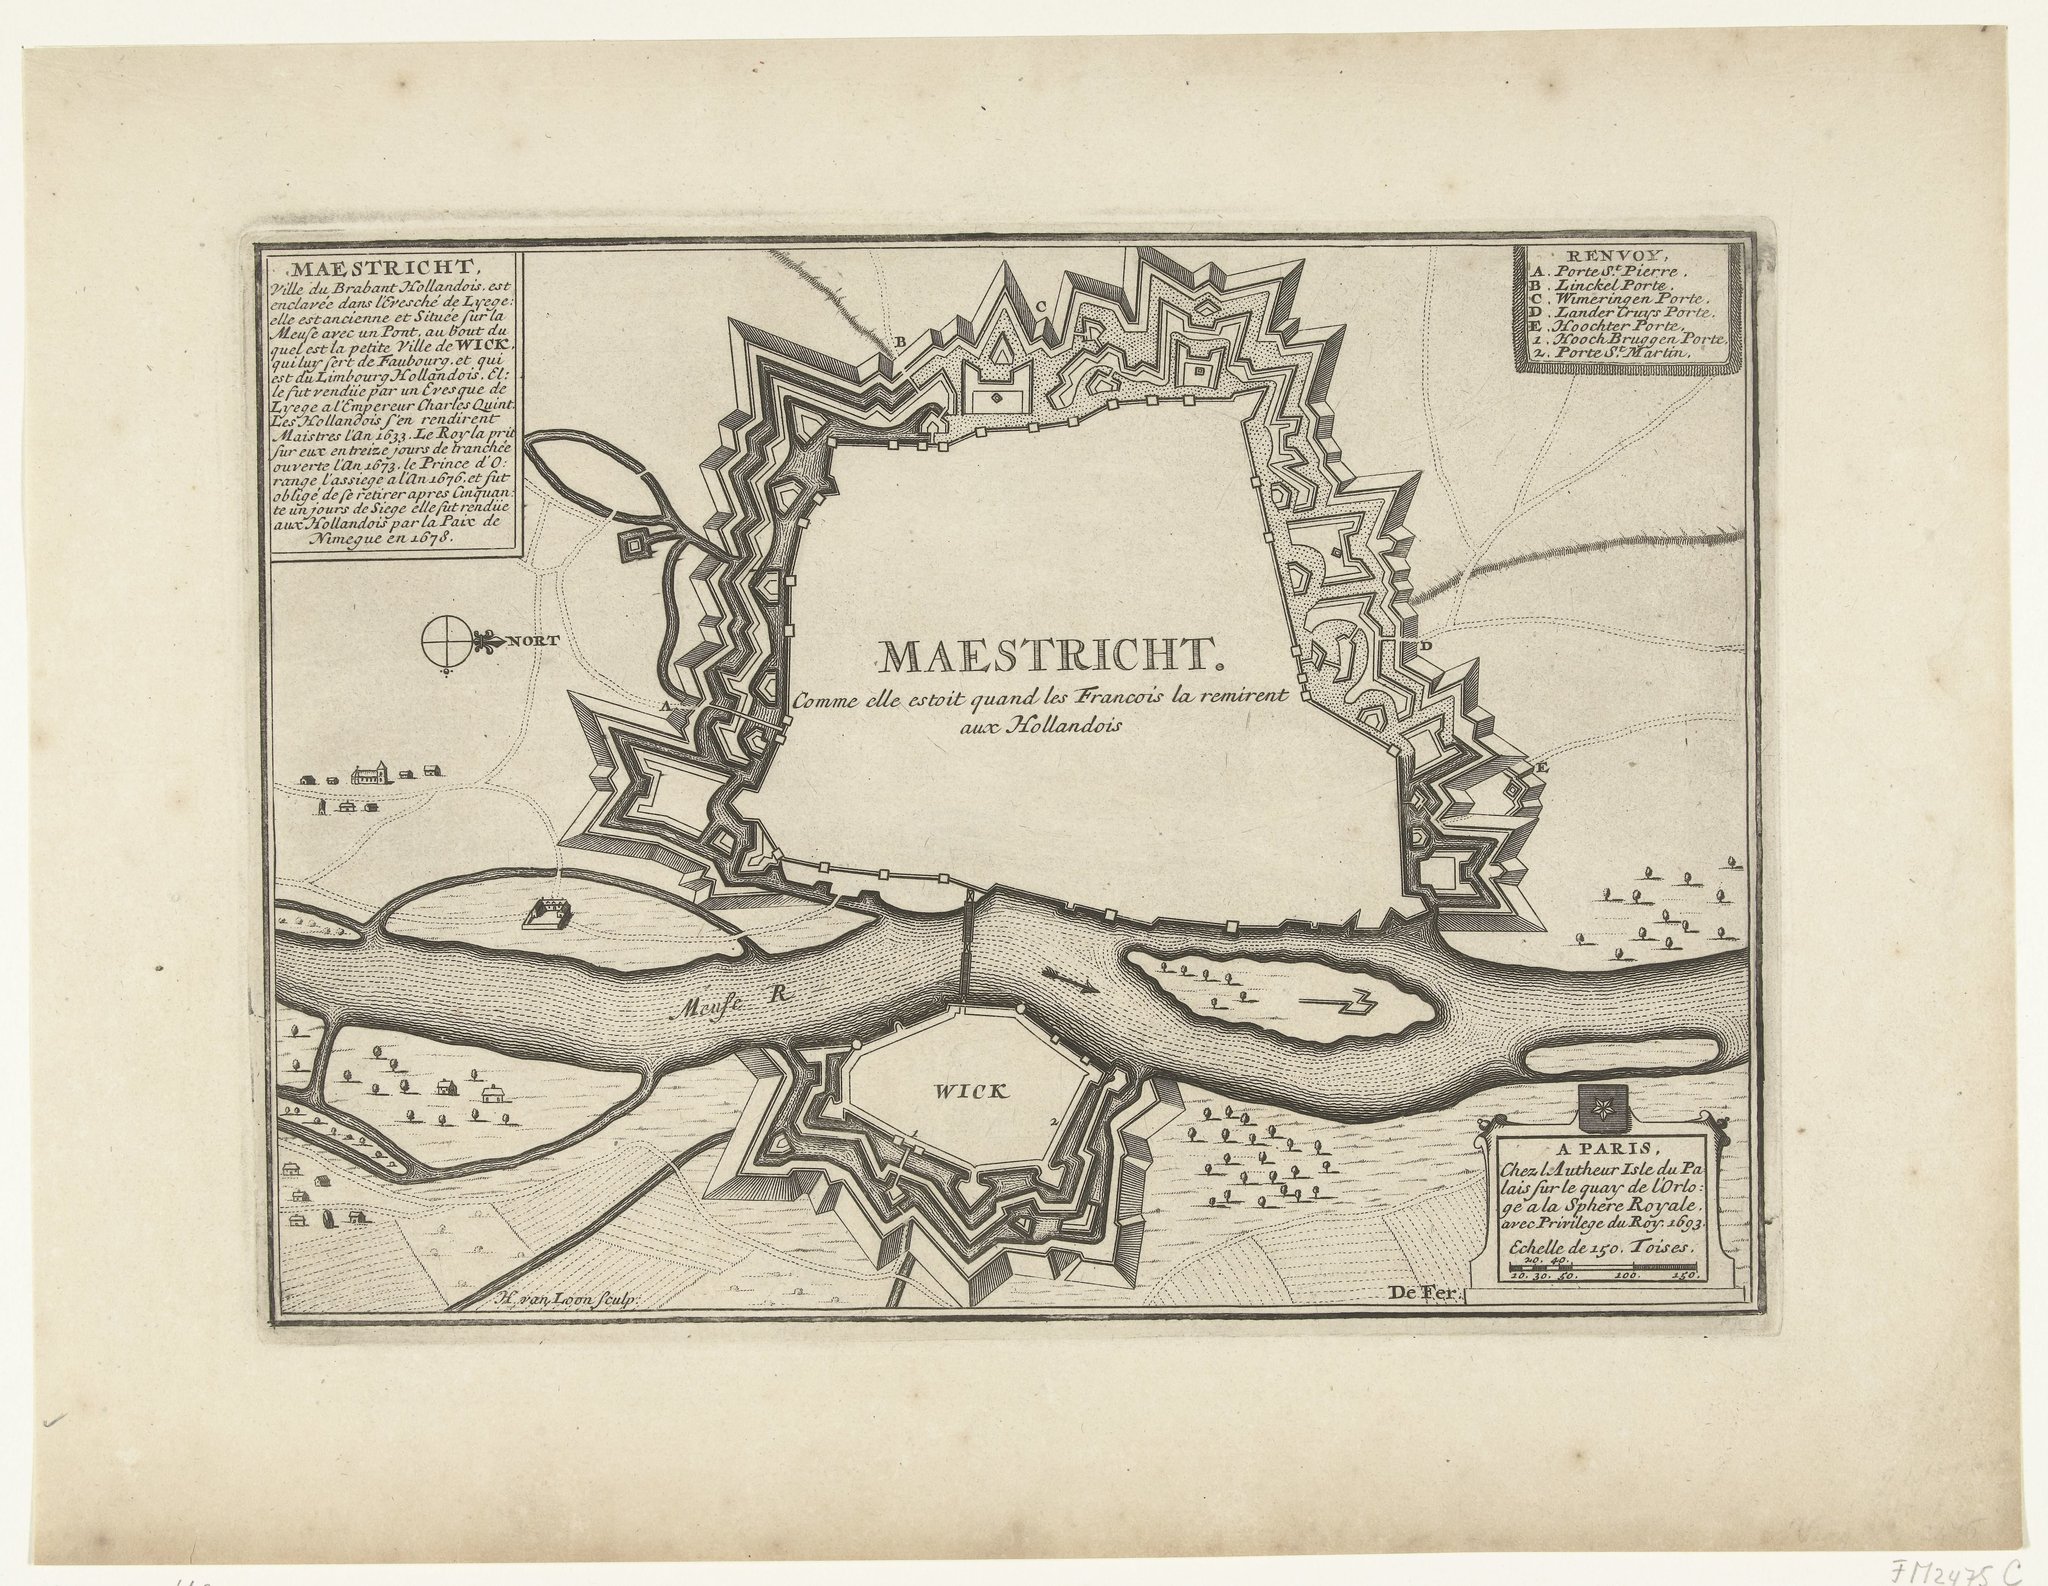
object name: print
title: Maestricht. Comme elle estoit quand les Francois la remirent aux Hollandois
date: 1693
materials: paper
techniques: etching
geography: paris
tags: siege, position war, maps of cities, maastricht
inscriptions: date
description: Plattegrond van de versterkingen rondom Maastricht, belegerd en veroverd door het Franse leger, 27-30 juni 1673. Linksboven een cartouche met een overzichtje van de historie van de stad vanaf 1633 tot 1678. Rechtsboven de legenda A-E en 1-2 in het Frans.